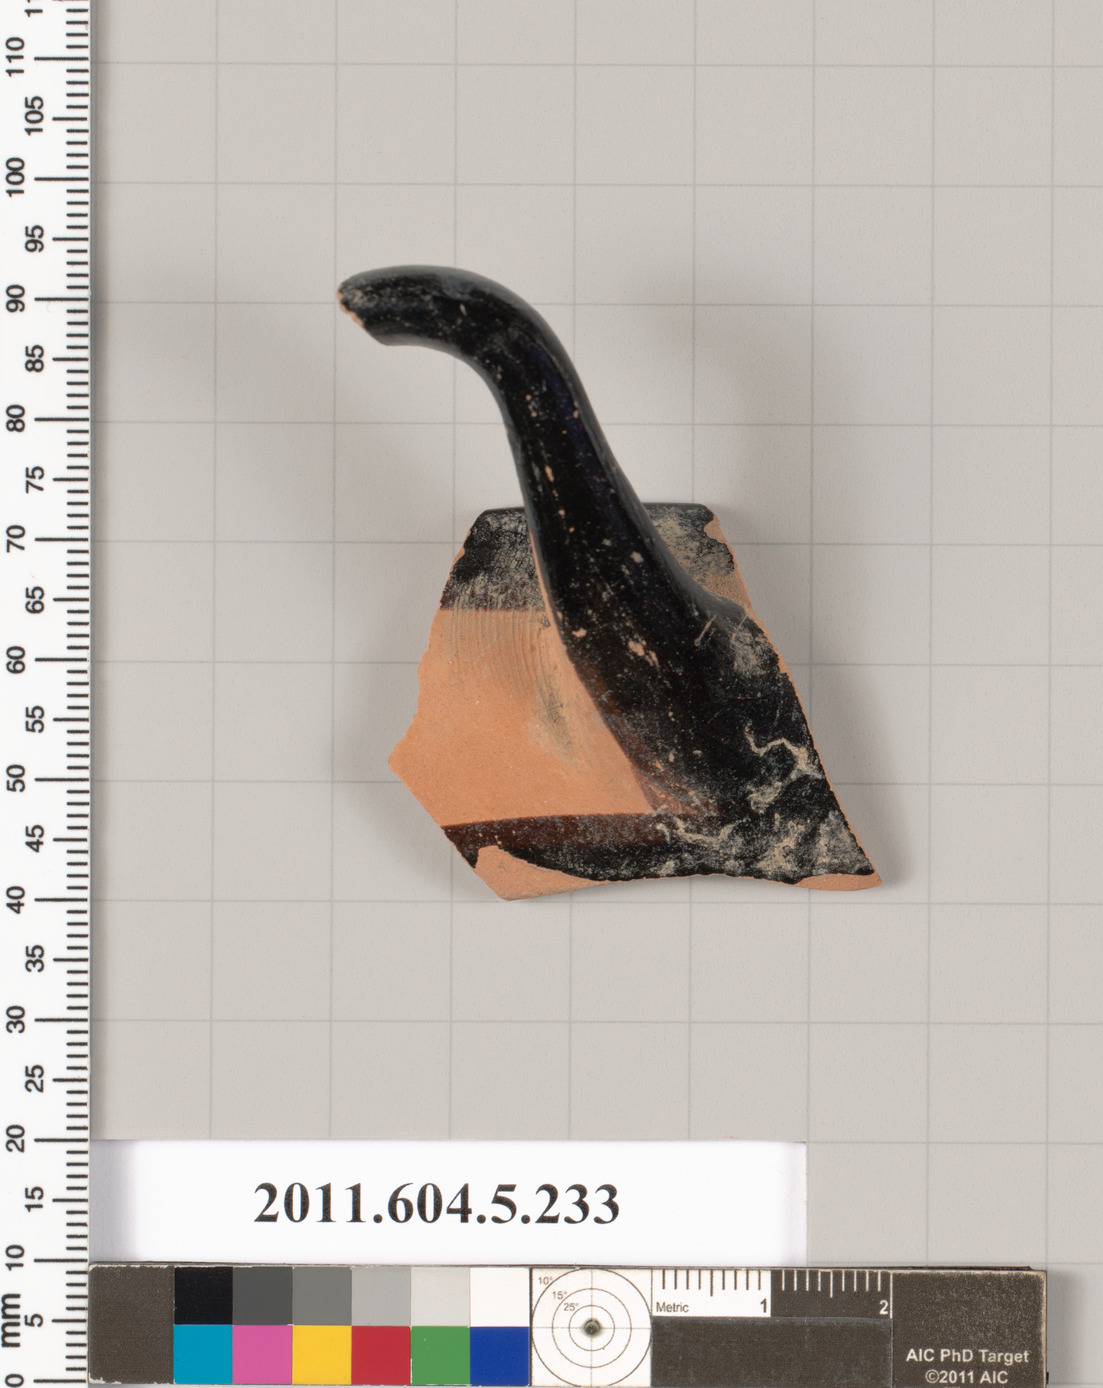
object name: kylix fragment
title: Terracotta rim fragment of a kylix (drinking cup)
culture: greek, attic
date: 600-401 BCE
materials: terracotta